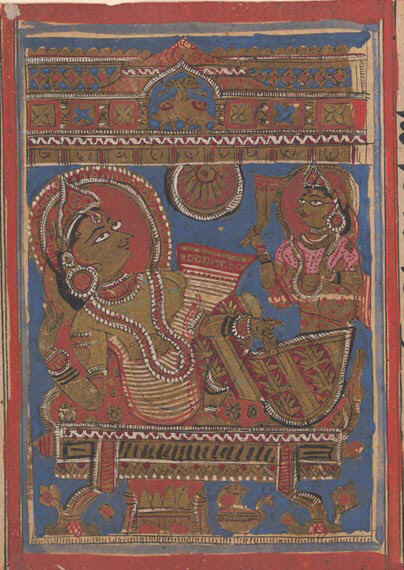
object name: folio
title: Trisala on Her Couch (left) / The Goddess Sri, One of the Fourteen Lucky Dreams (right); Page from a Dispersed Kalpa Sutra (Jain Book of Rituals)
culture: indian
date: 1401-1500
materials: gold, ink, paper, watercolor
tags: mothers,goddess,couches